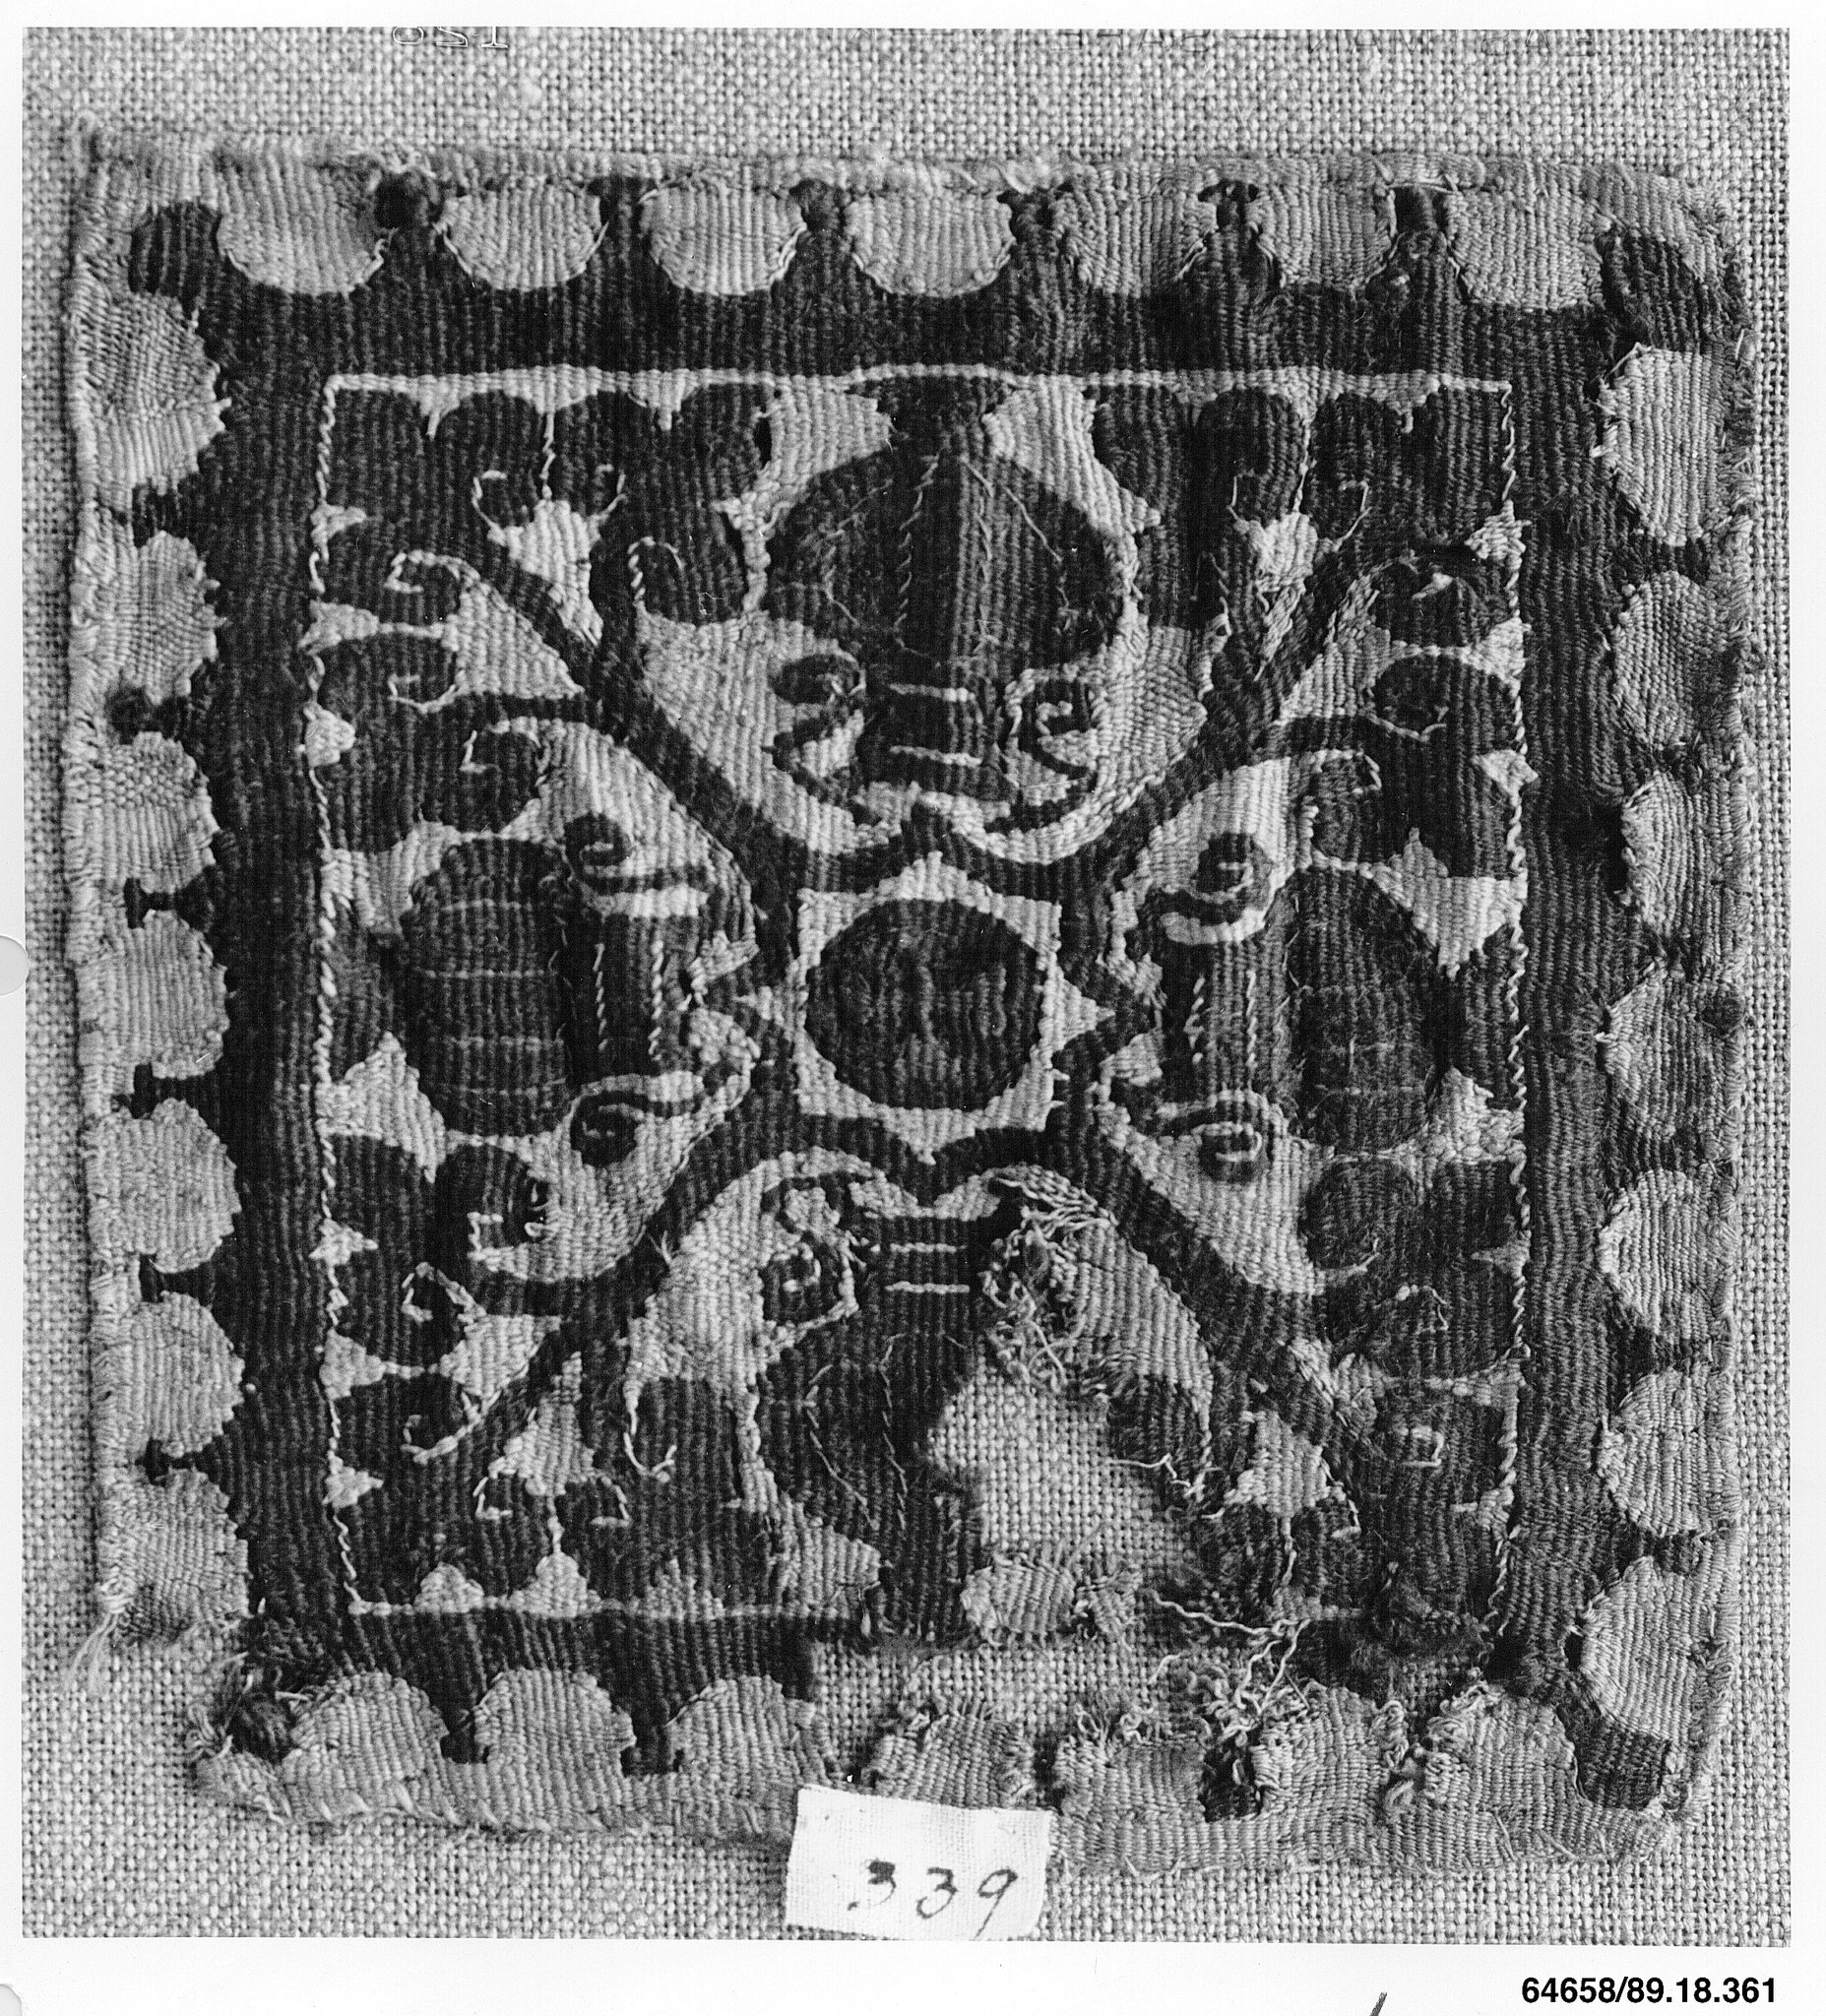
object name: textile fragment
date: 301-400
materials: linen, wool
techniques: weave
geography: egypt